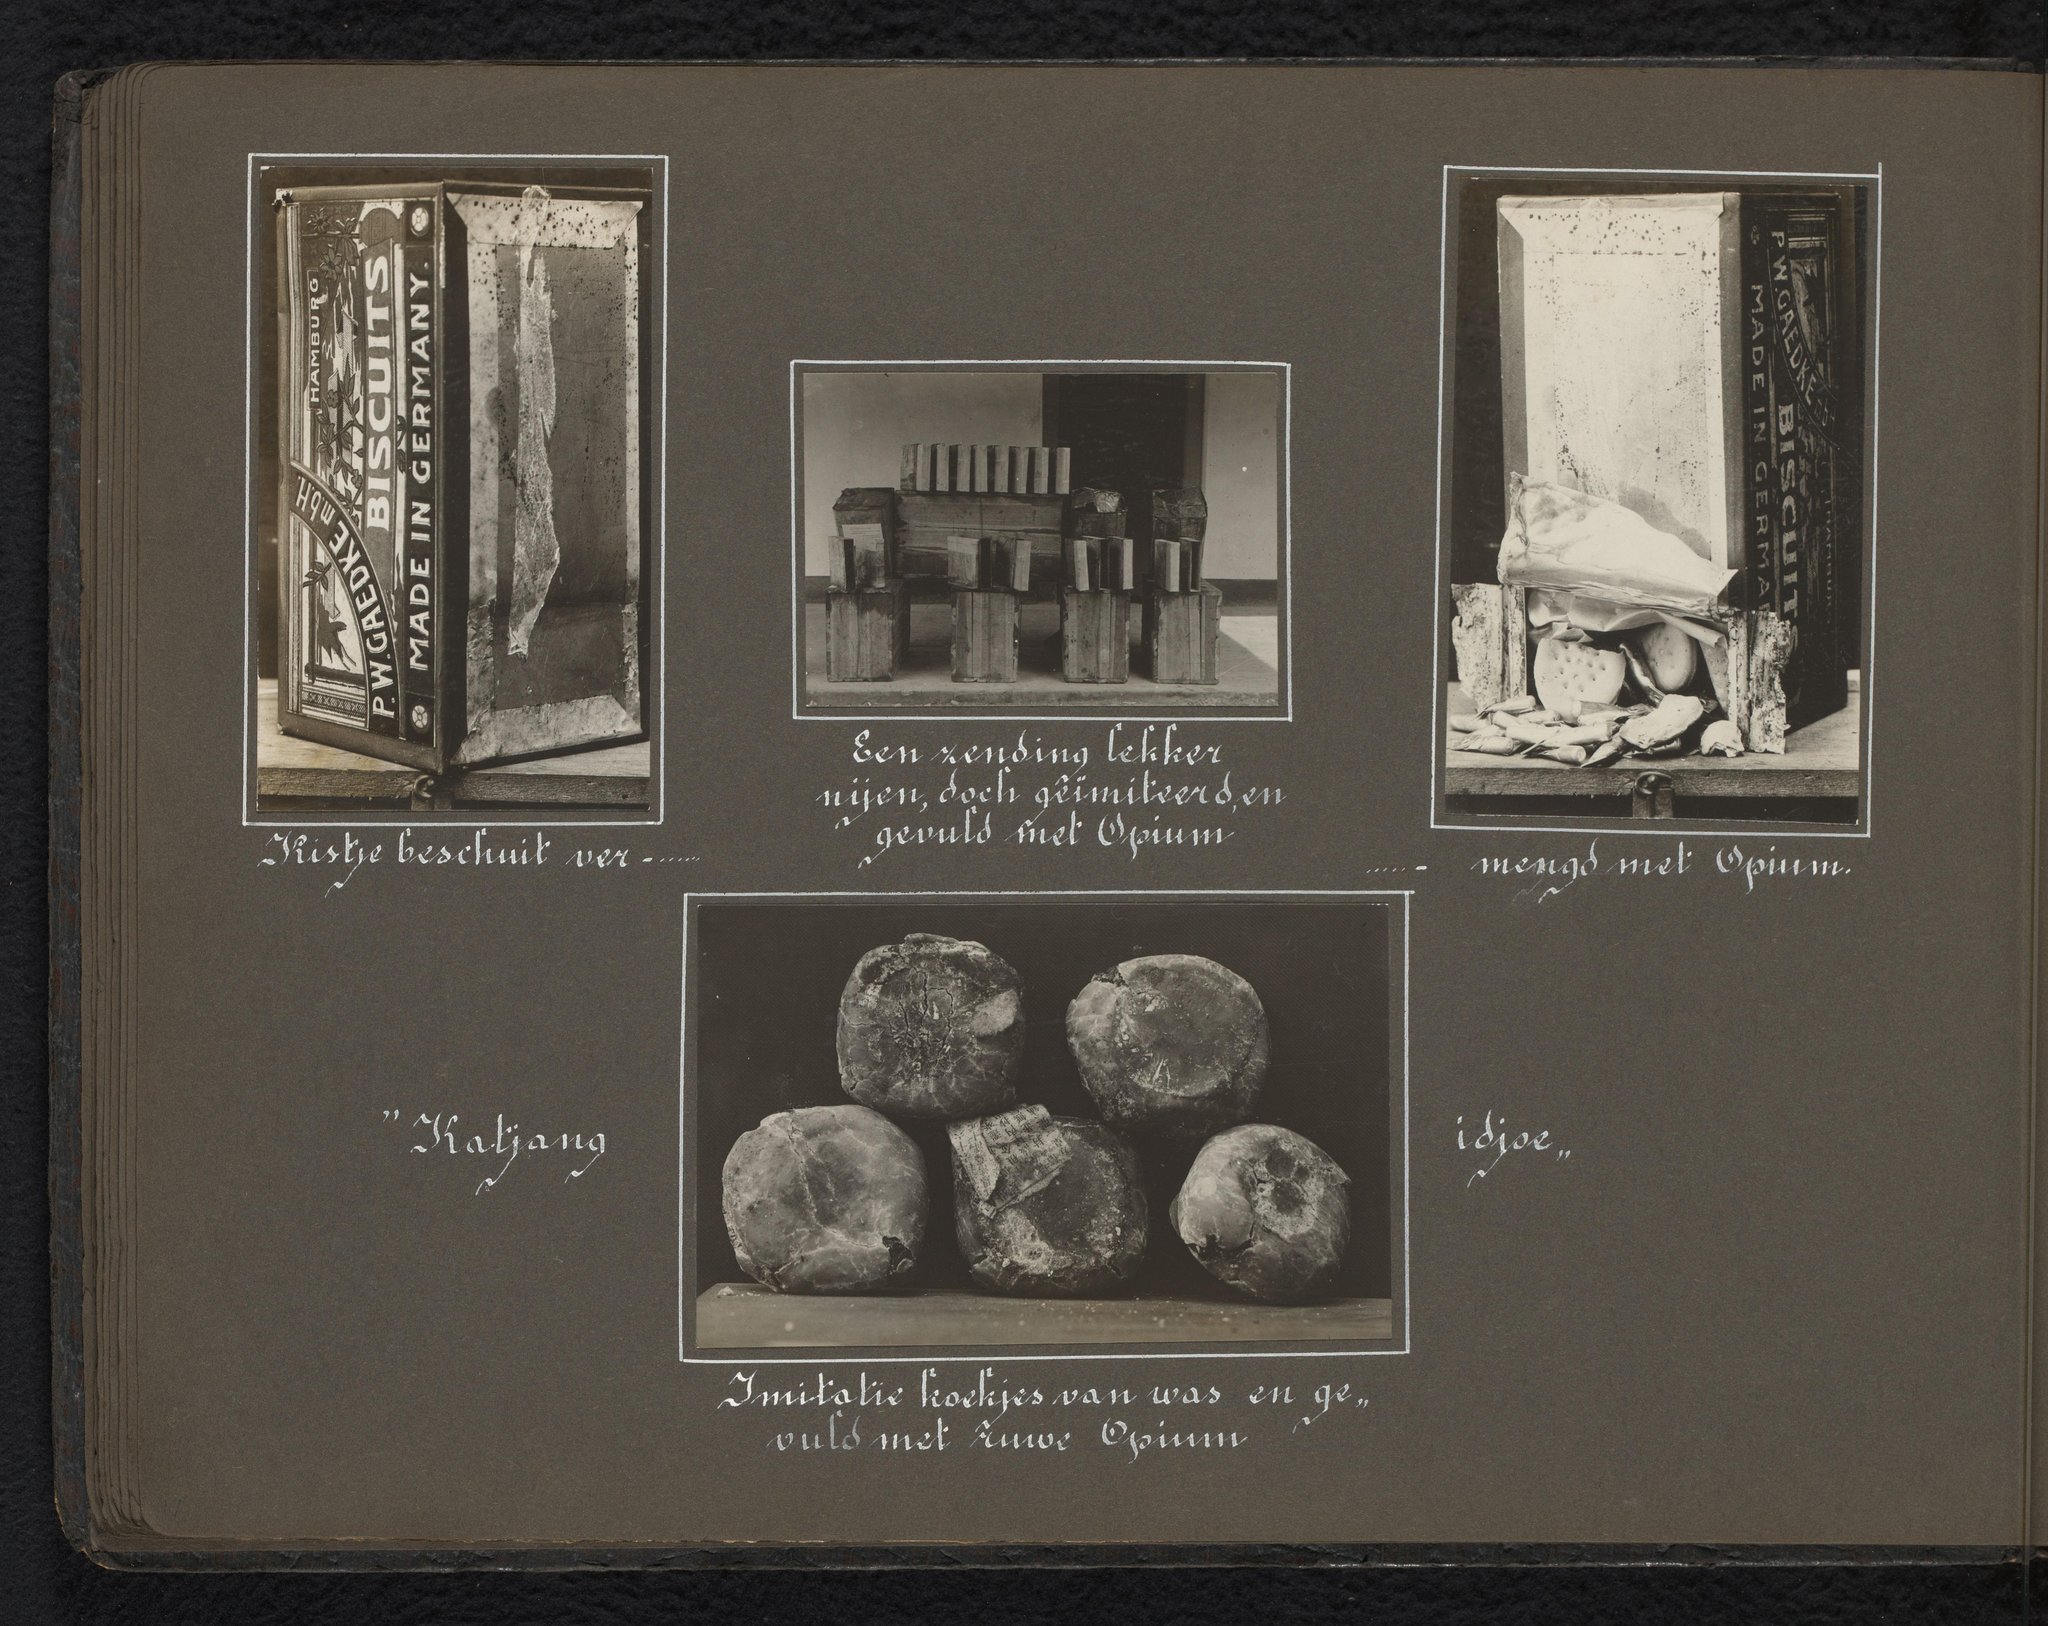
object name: photograph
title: Opium gesmokkeld tussen beschuit en koekjes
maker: Anonymous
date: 1920-1930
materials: cardboard, photographic support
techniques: gelatin silver print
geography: dutch east indies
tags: opium, trade and smuggling of drugs, policeman, constable, dutch east indies, the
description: Albumblad met vier foto's van een kist beschuit, kisten met lekkernijen en imitatiekoekjes waarin opium werd gesmokkeld. Onderdeel van het fotoalbum uit 1930 met politiefoto's over de opiumsmokkel in Indië.